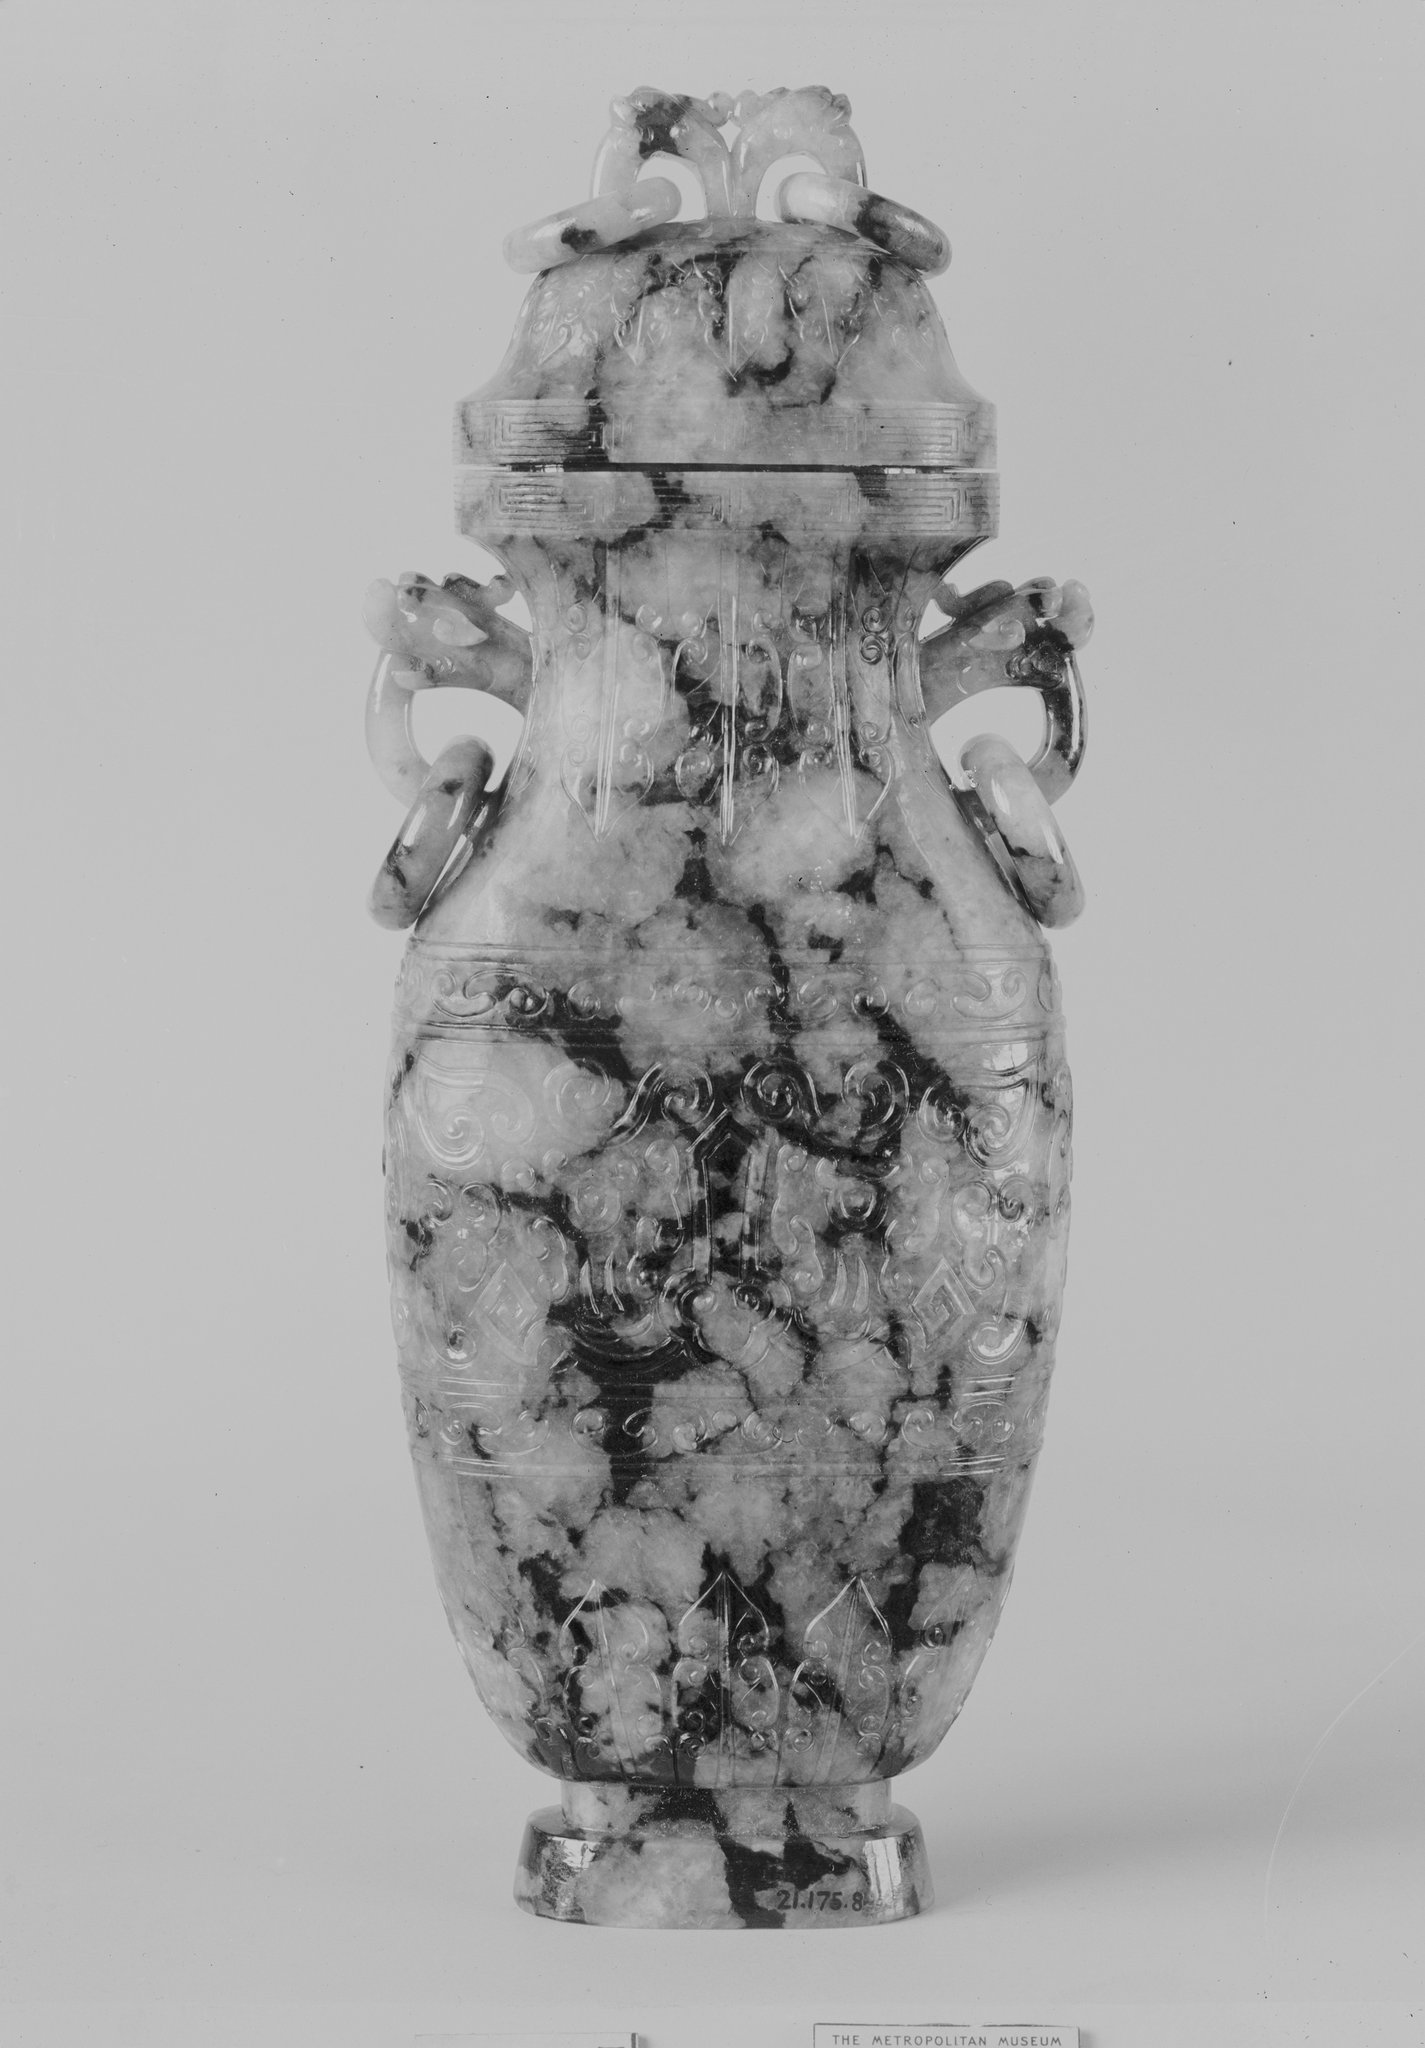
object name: covered vase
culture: chinese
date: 1801-1900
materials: jade